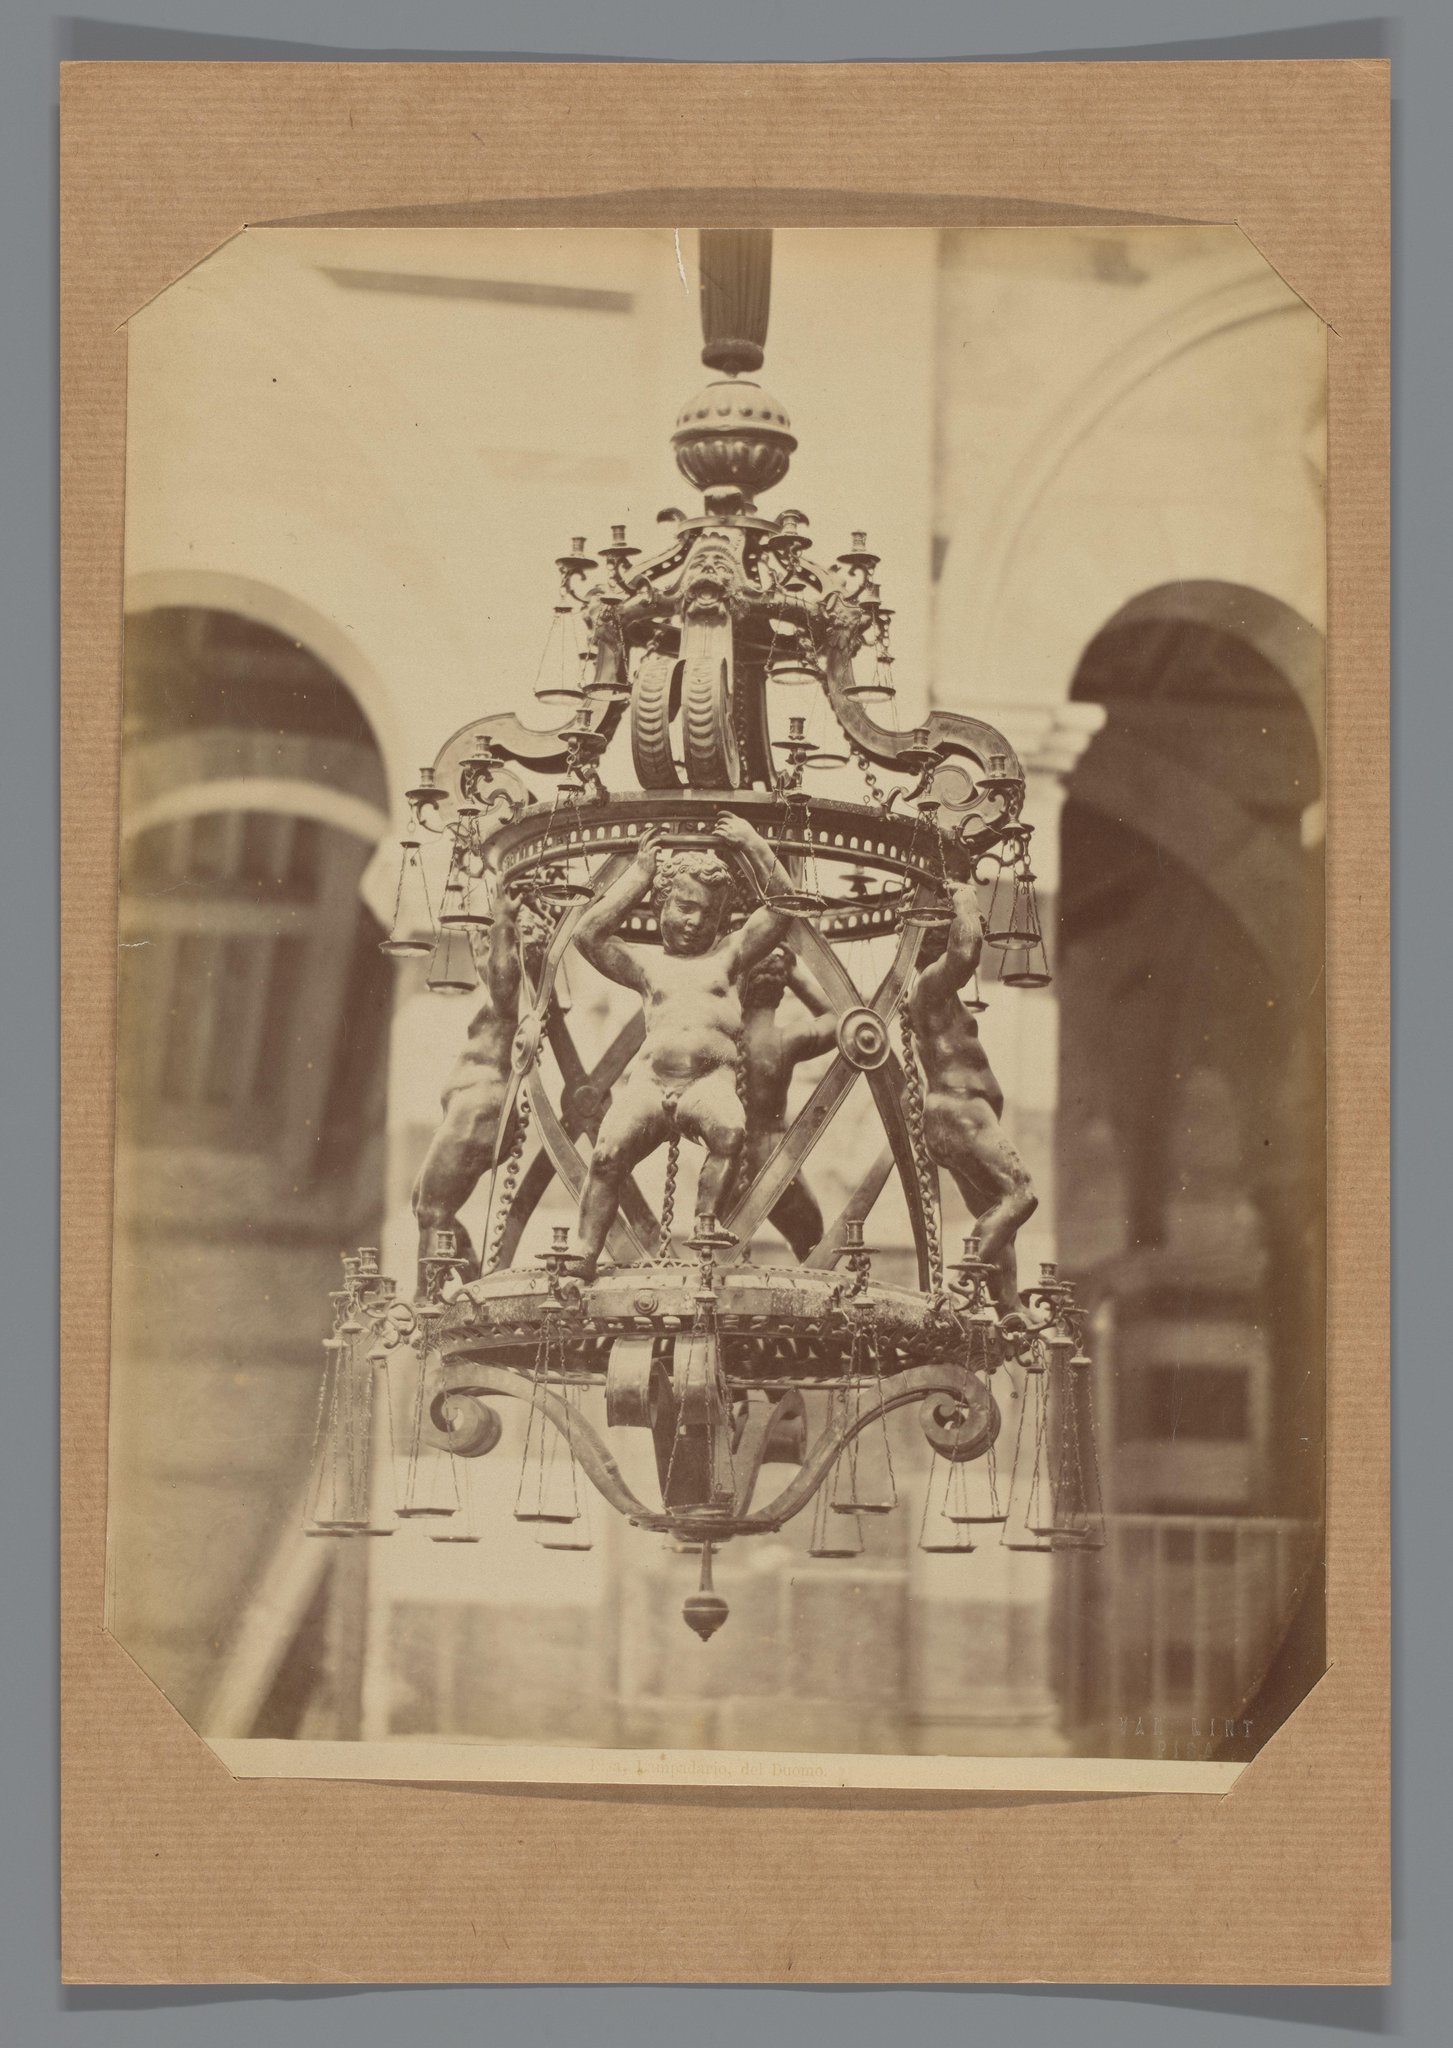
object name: photograph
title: Italië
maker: Anonymous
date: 1880-1910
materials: photographic support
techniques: albumen print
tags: italy